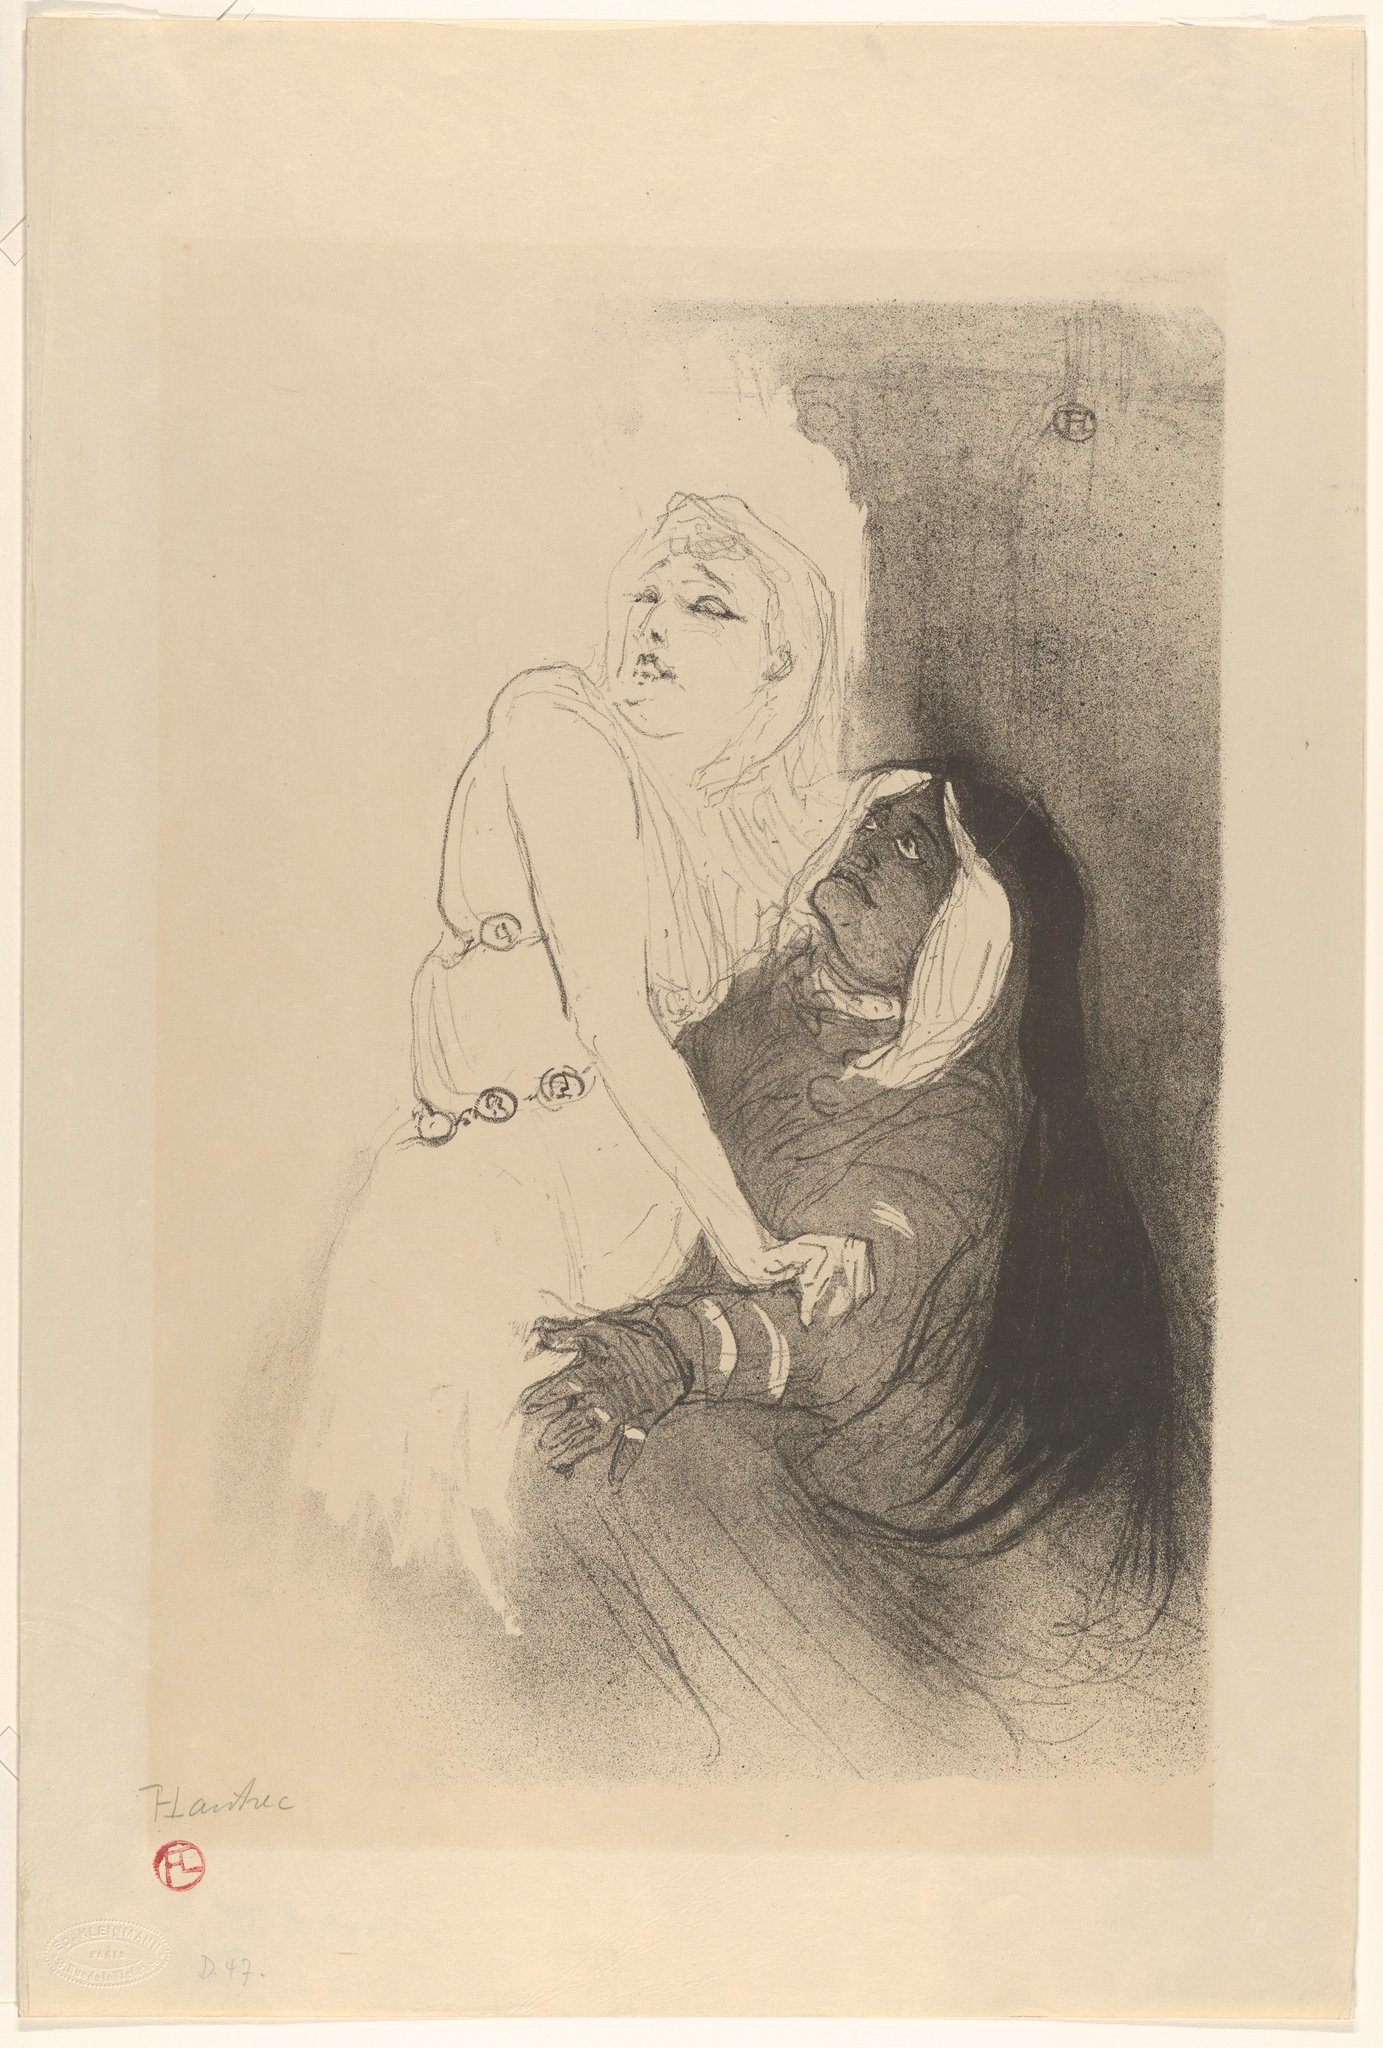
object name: print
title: At the Théâtre de la Renaissance: Sarah Bernhardt in Phèdre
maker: henri de toulouse-lautrec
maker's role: artist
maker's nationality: french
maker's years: 1864-1901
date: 1893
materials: crayon, paper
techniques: brush, lithograph, printing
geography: france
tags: women